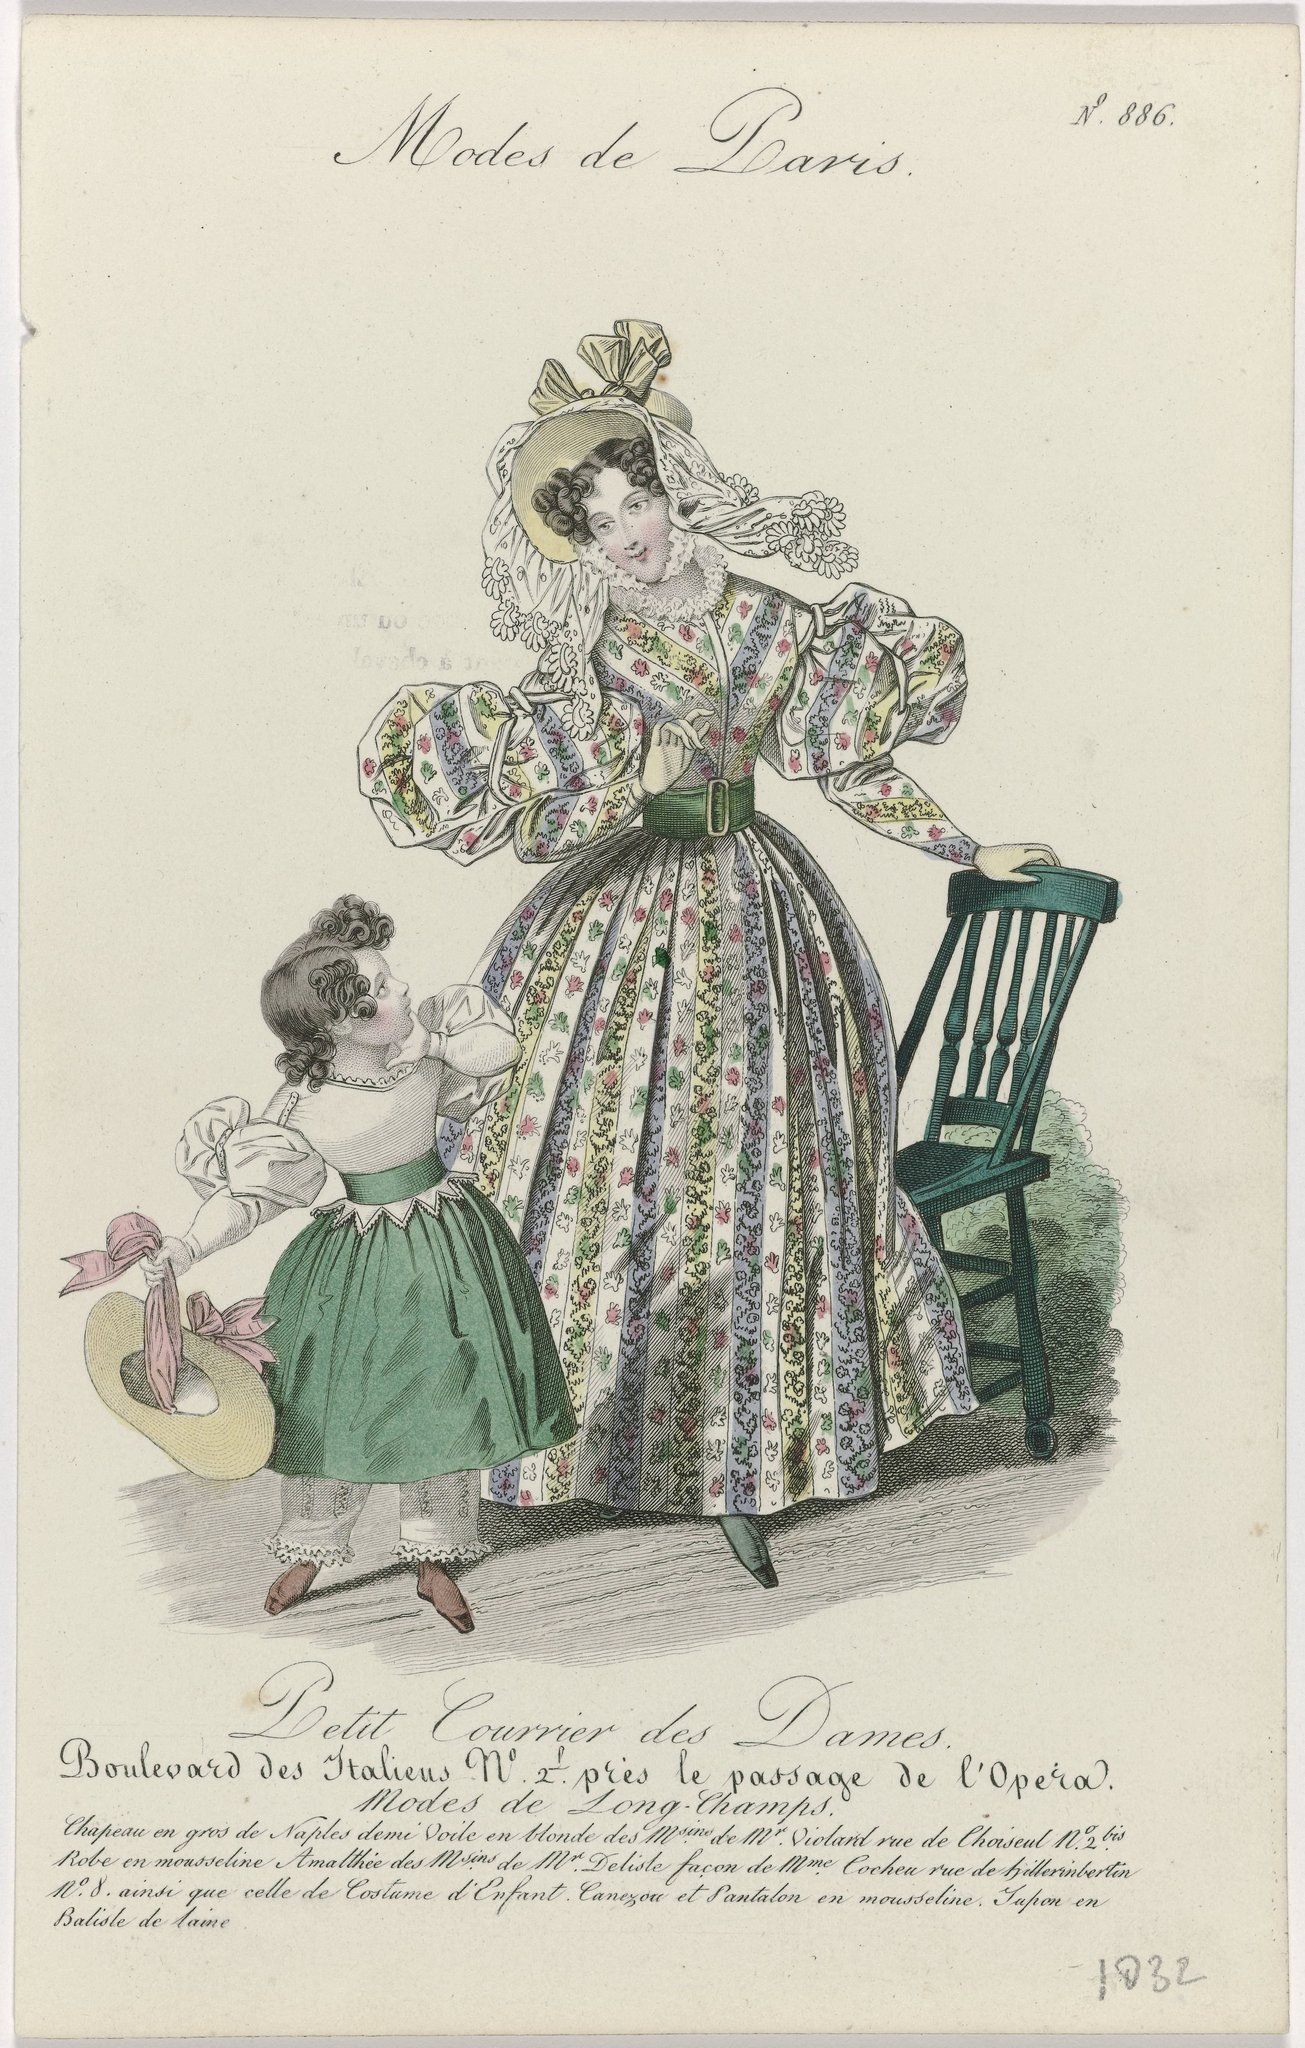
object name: fashion print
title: Petit Courrier des Dames, 1832, No. 886 : Chapeau en gros de Naples (...)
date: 1832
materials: paper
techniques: engraving, hand coloring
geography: paris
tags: skirt (+ girls' clothes), veil (+ lace used for clothes), head-gear: hat (+ girls' clothes), underclothes for the lower part of the body: bloomers (+ girls' clothes), clothing for the upper part of the body: blouse (+ girls' clothes), fashion plates, head-gear: hat (+ women's clothes), gloves, mittens, etc. (+ women's clothes), dress, gown (+ women's clothes)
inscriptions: address: ‘Boulevard des Italiens No.2 près le passage de l'Opèra.’, title: ‘Petit Courrier des Dames.’, title: ‘Modes de Paris.’, caption: ‘Modes de Long-Champs. / Chapeau en gros de Naples demi Voile en blonde des M.sins de Mr. Violard rue de Choiseul No. 2 bis Robe en mousseline Amalthée des M.sins de Mr. Delisle façon de M.me Cocheu rue de hillerin bertin No. 8 ainsi que celle de Costume d'Enfant. Canezou et Pantalon en mousseline. Jupon en Batiste de laine.’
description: Hoed van 'gros de Naples' met halve sluier van Blonde (kloskant) uit de winkels van Mr Violard. Japon van 'mousseline Amalthée' en het kinderkleding uit de winkels van Mr Delisle en uitgevoerd op de manier van Cocheu. 'Canezou' en lange broek (bloomers) van mousseline. Rok van 'batiste de laine' (wol batist?). Prent uit het modetijdschrift Petit Courrier des Dames (1821-1868).